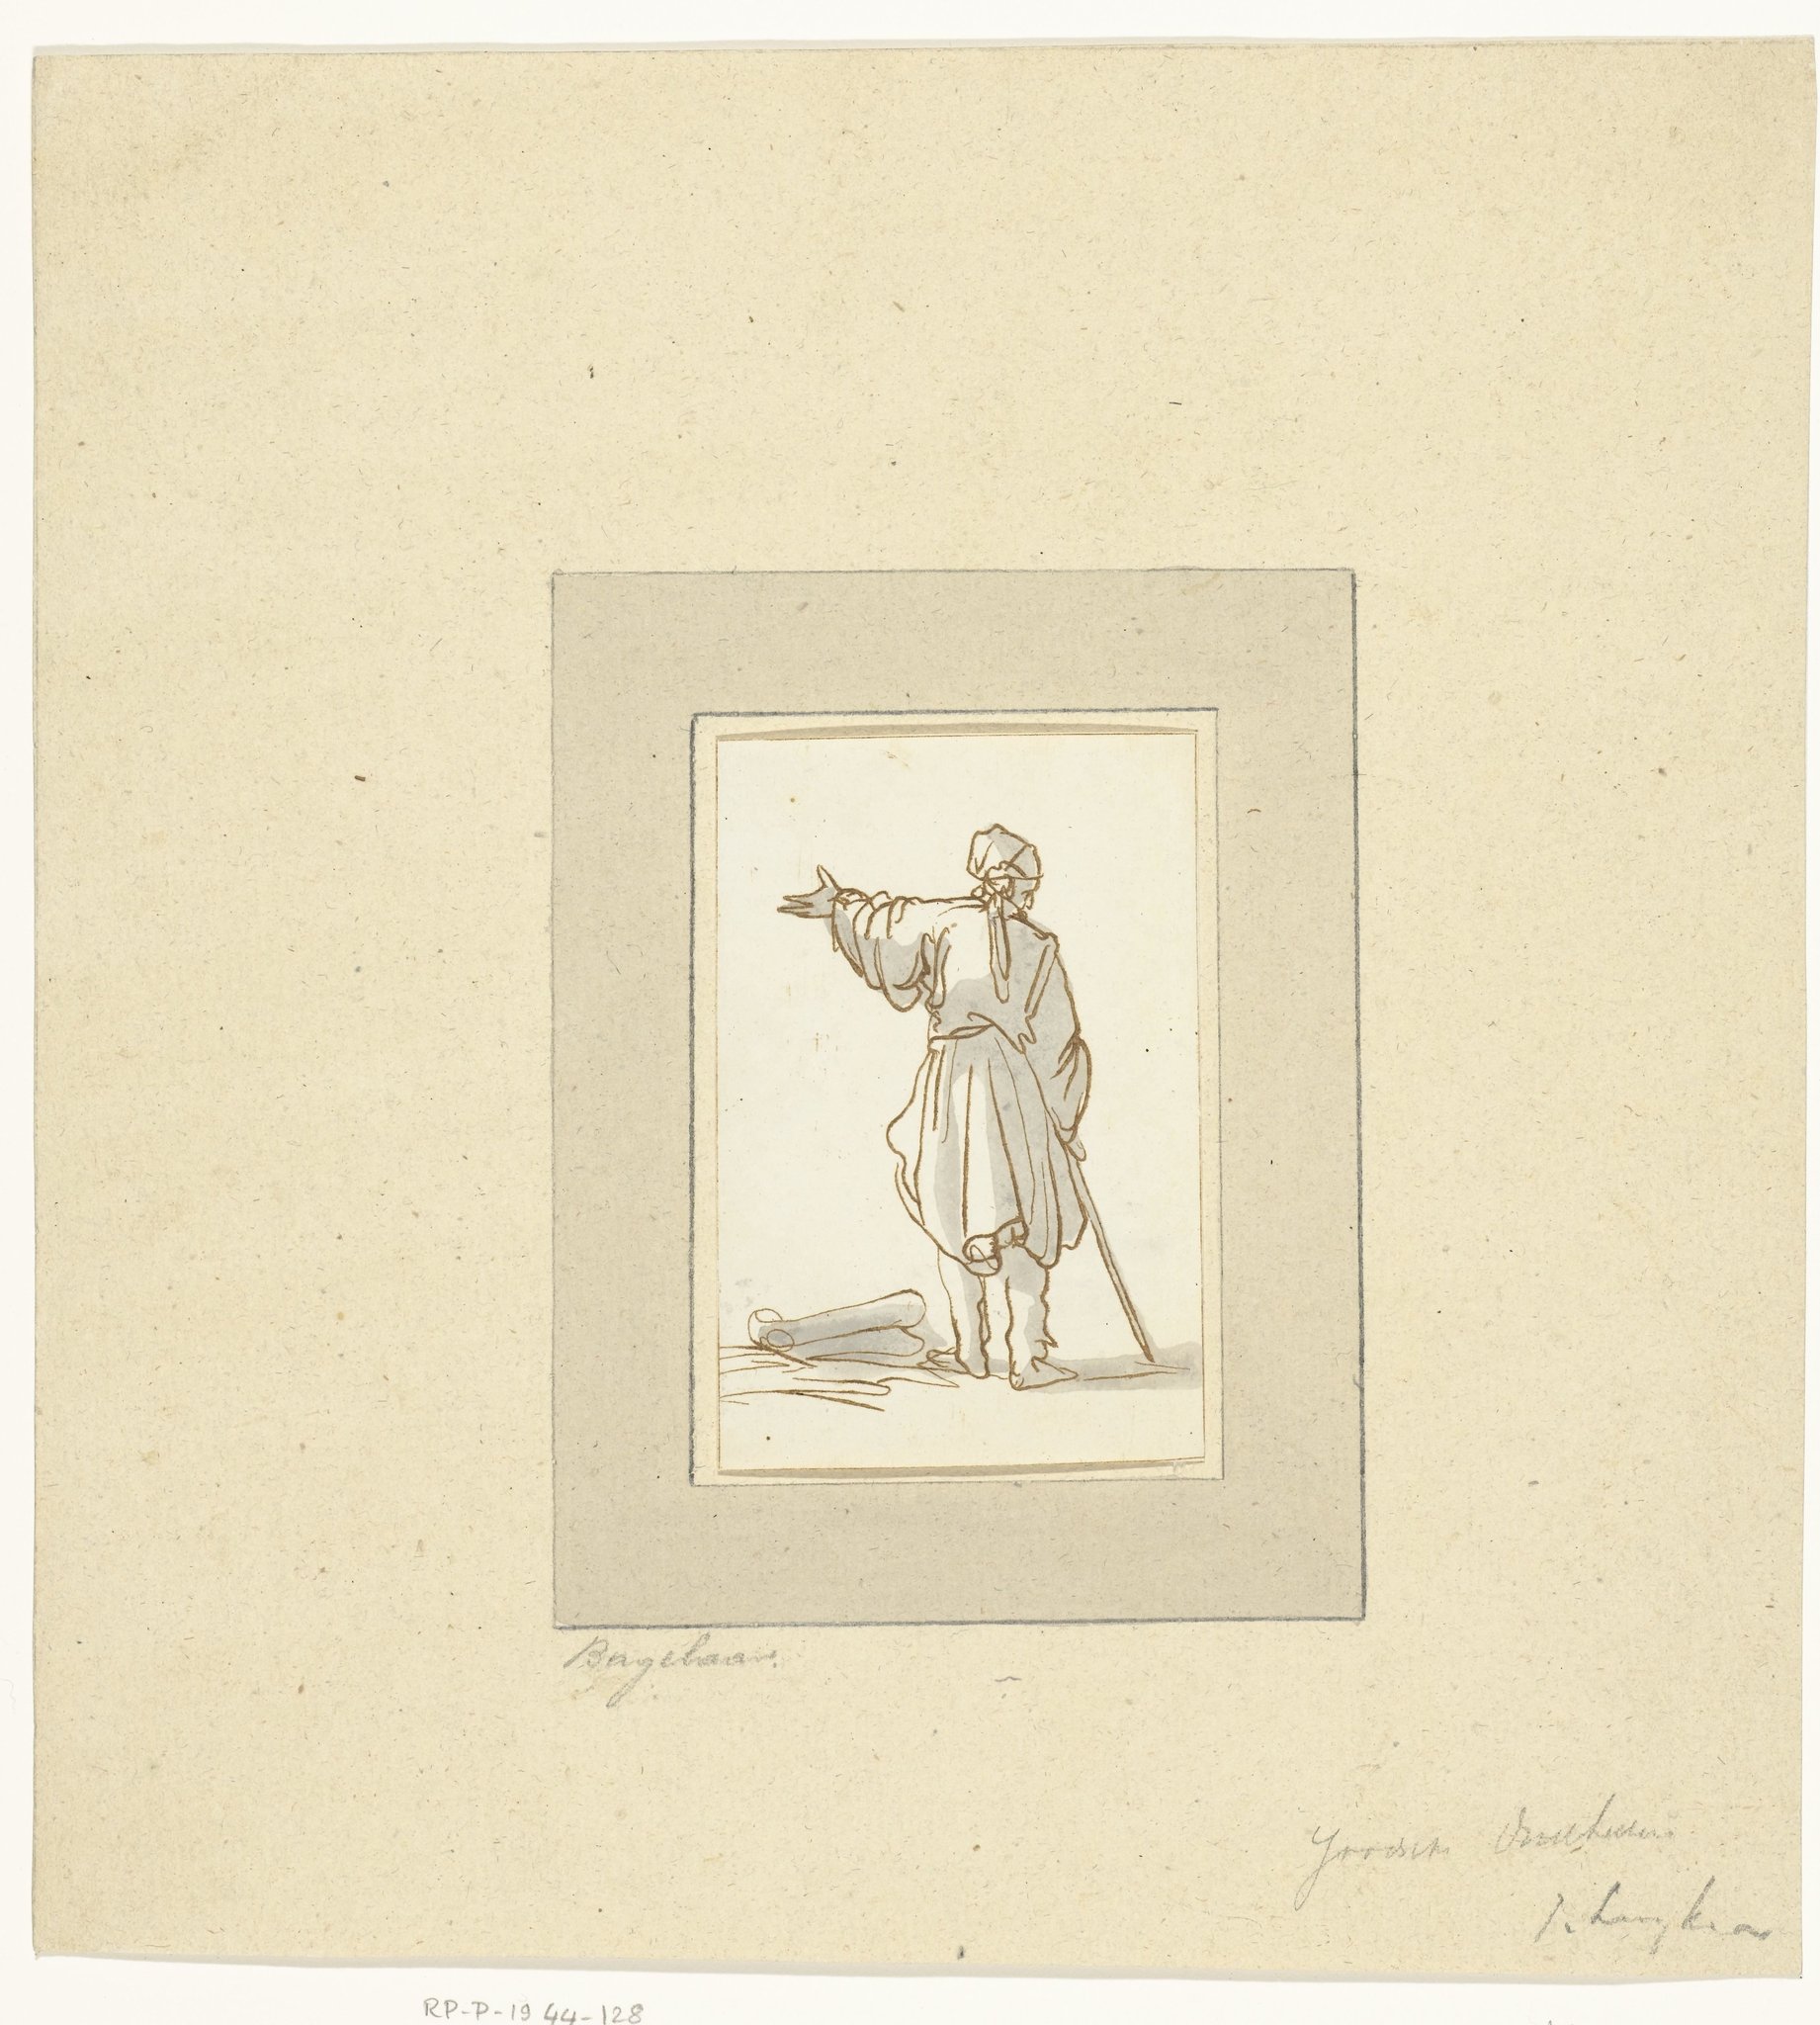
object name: print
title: Man met stok, op zijn rug gezien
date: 1798-1837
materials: paper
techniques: printing, etching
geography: netherlands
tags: adult man (+ back view)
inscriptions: collector's mark: Lugt 2228, inscription: ‘gedrukt met roest en oostindische ink [...] Bagelaar fecit’